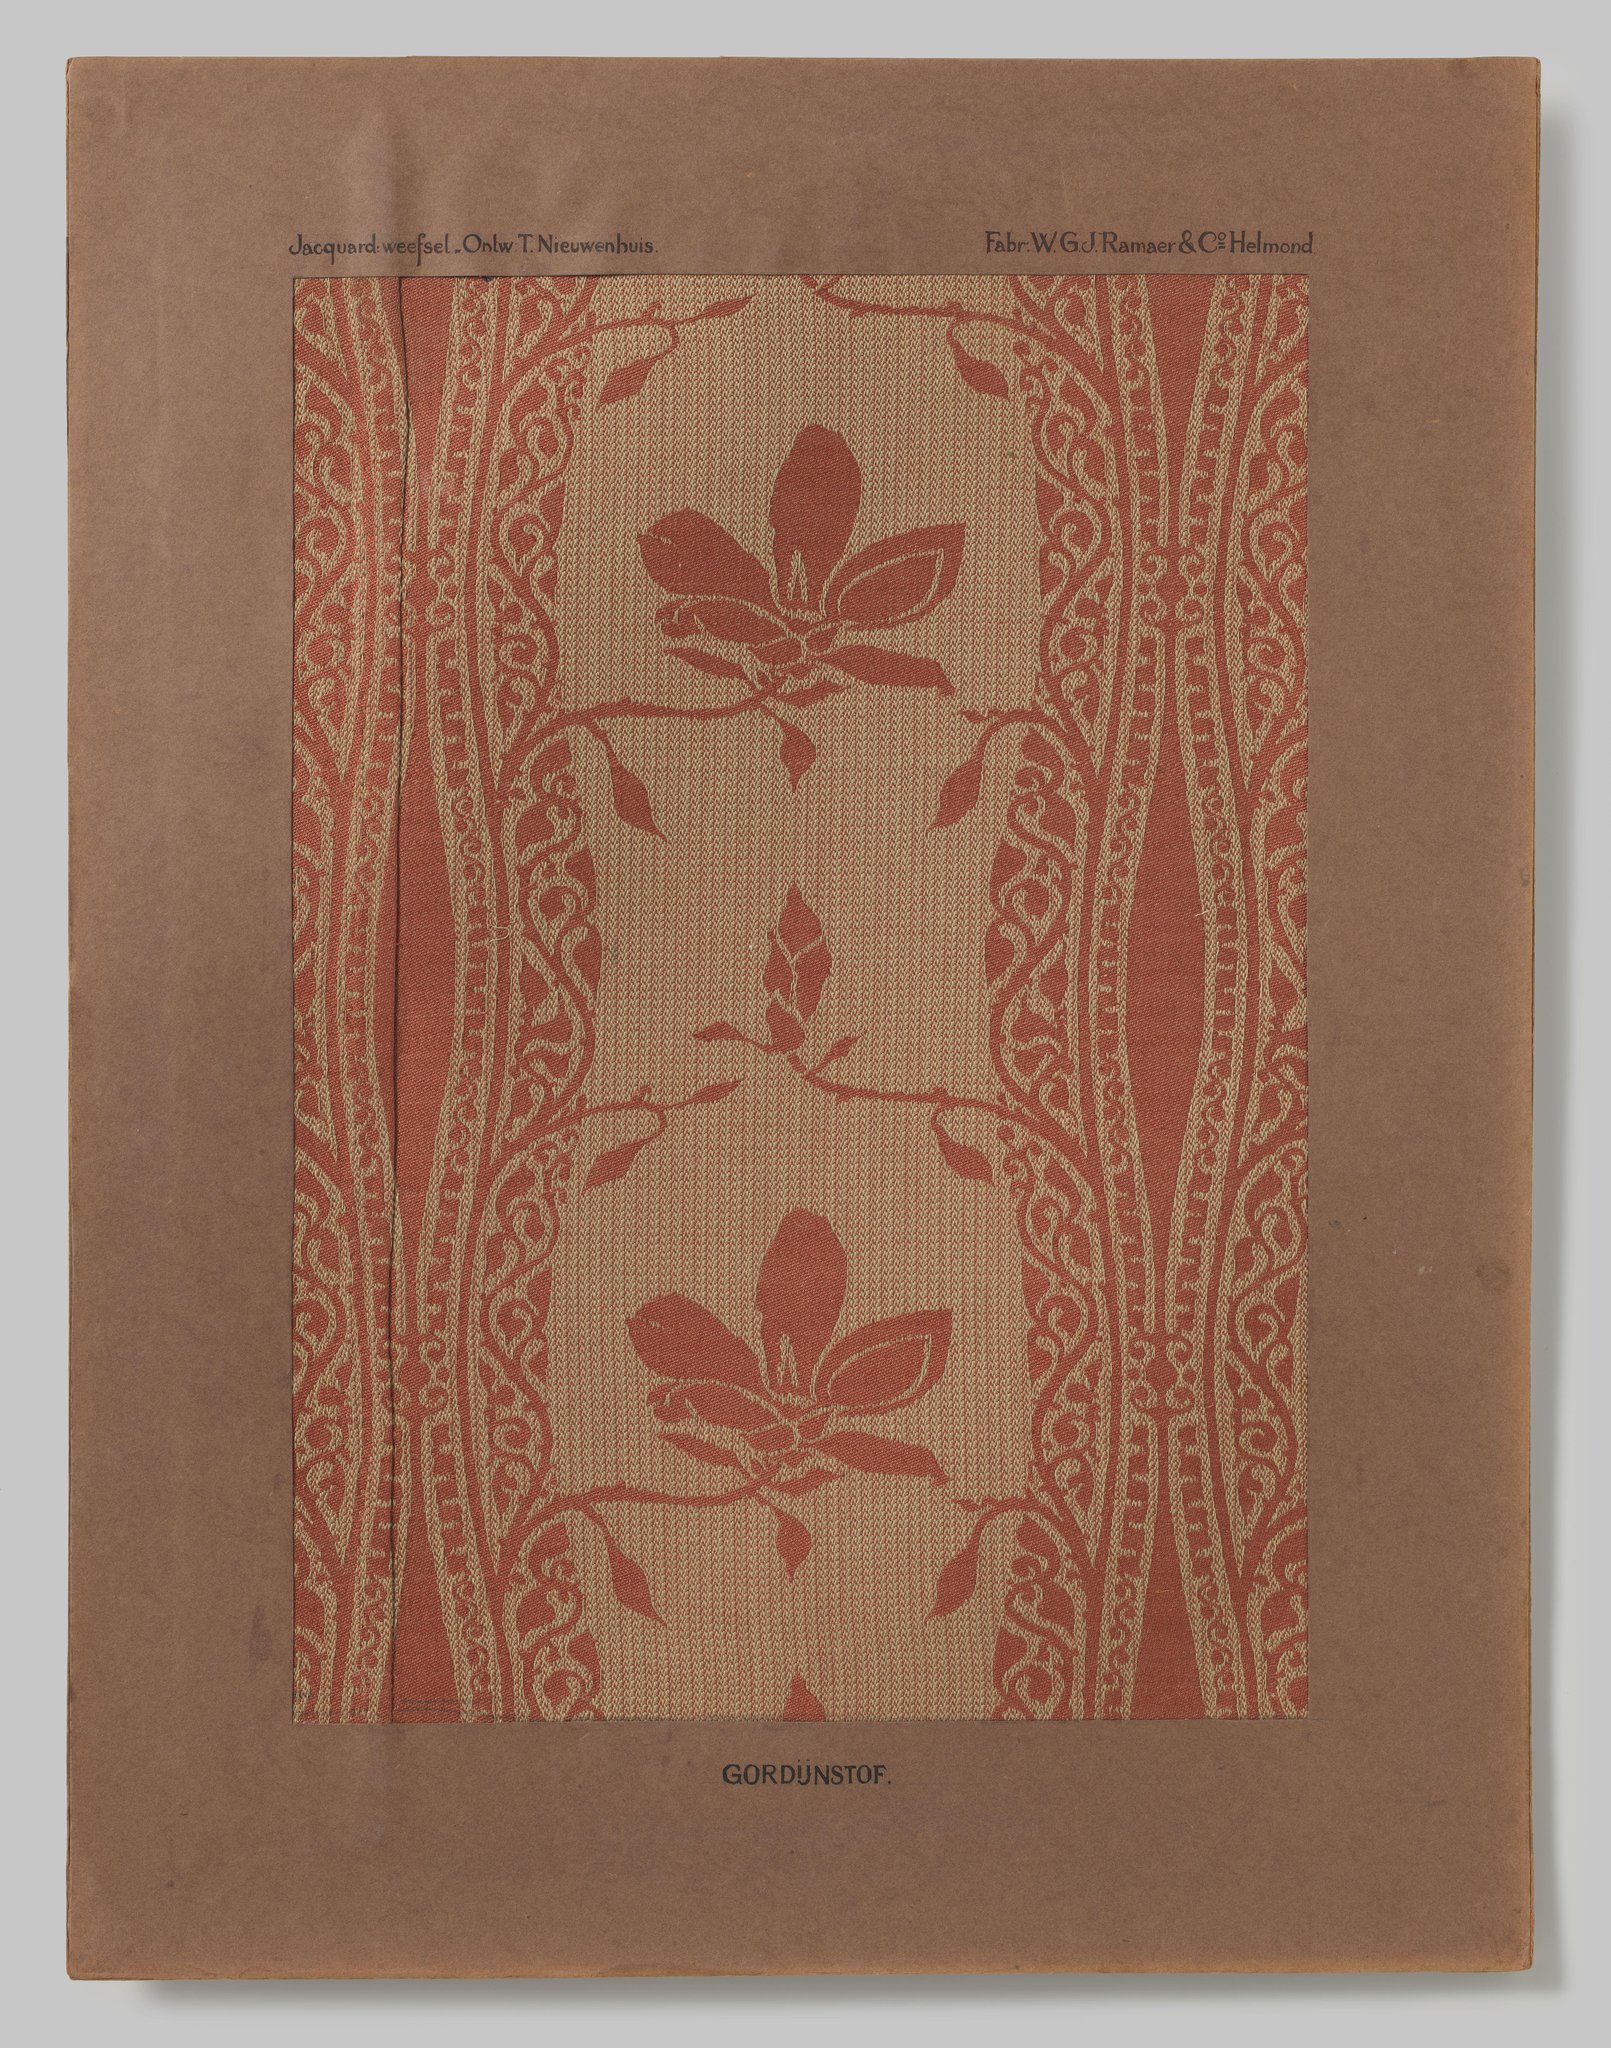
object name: sample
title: Staal gordijnstof naar ontwerp van Theo Nieuwenhuis in passe-partout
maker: theo nieuwenhuis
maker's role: designer, draughtsman, print maker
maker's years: 1866-1951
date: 1910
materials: cardboard, cotton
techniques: jacquard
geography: netherlands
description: Staal gordijnstof van jacquardgeweven katoen naar ontwerp van Theo Nieuwenhuis, in origineel passe-partout. Het staal bestaat uit twee aan elkaar genaaide stukken. Het patroon bestaat uit verticale banden bestaande uit geometrische en organische motieven, waaruit bloemtakken van magnolia groeien. Roodbruine inslag op lichtgroene ketting.